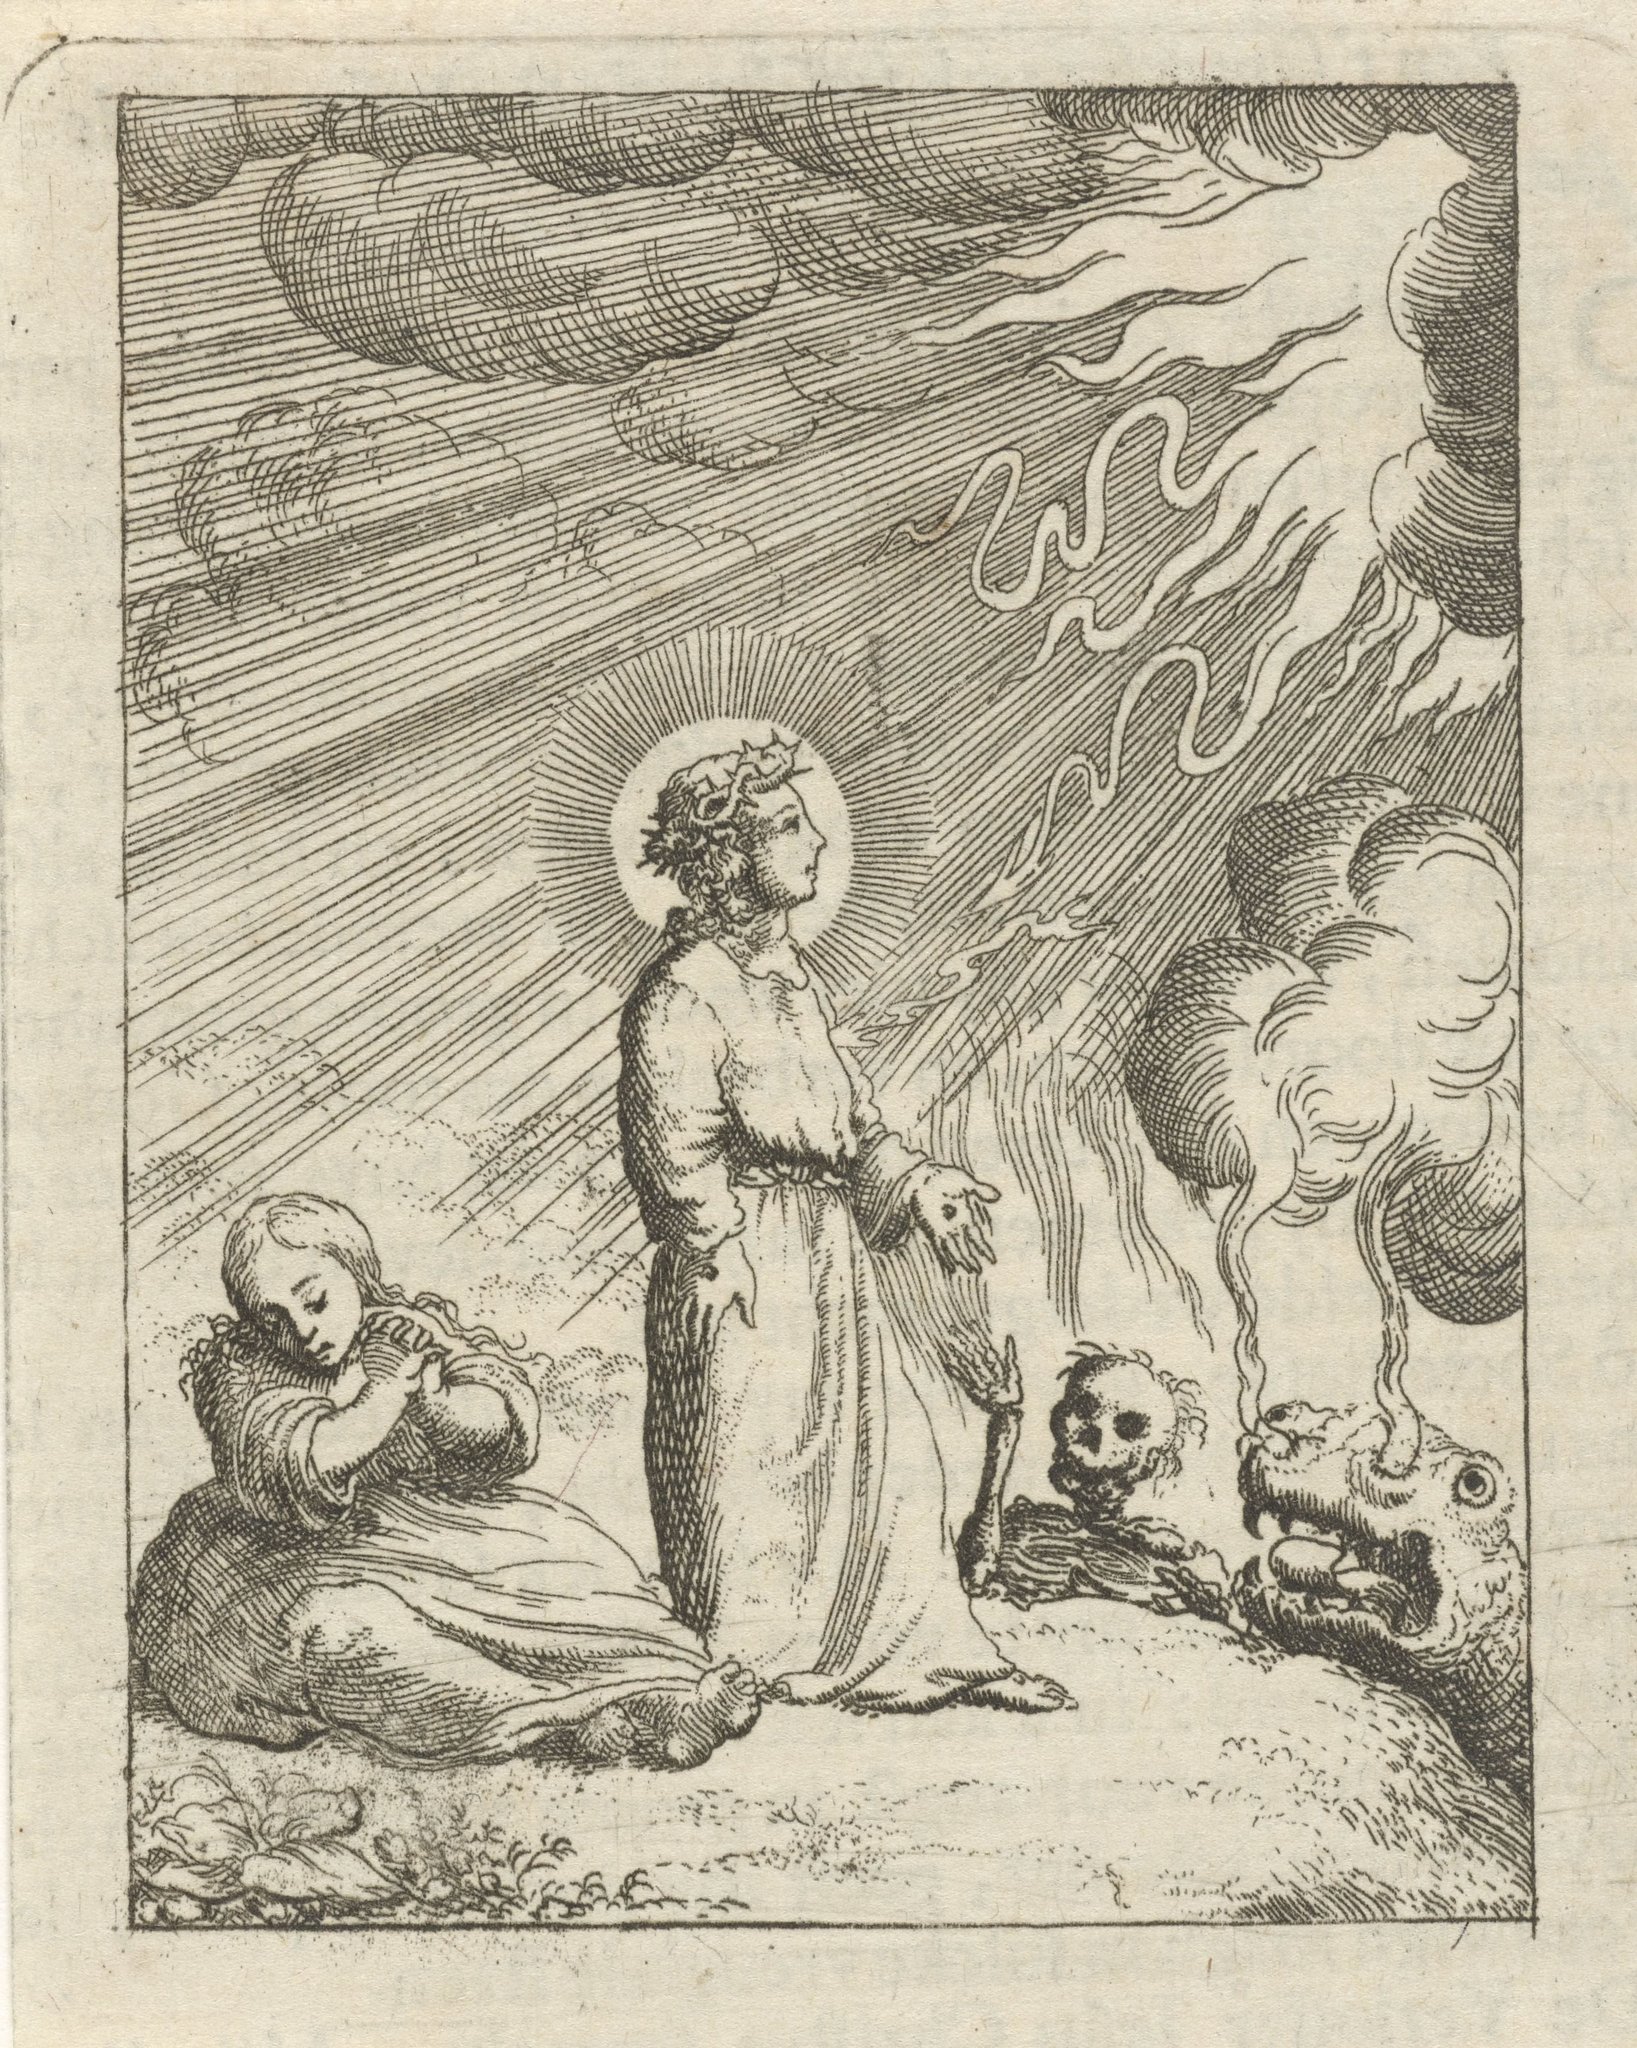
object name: print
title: Jezus verdedigt de Ziel tegen Hel en Dood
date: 1678-1687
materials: paper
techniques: etching, letterpress printing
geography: amsterdam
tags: symbols of hell, symbols of death, christ and the soul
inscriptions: collector's mark: Lugt 2228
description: Illustratie uit: Luyken, Jan. Jezus en de Ziel, 3 delen. Amsterdam: Pieter Arentsz II, 1678-1687. Tussen 1678-1744 verschenen van dit emblemataboek 10 edities.